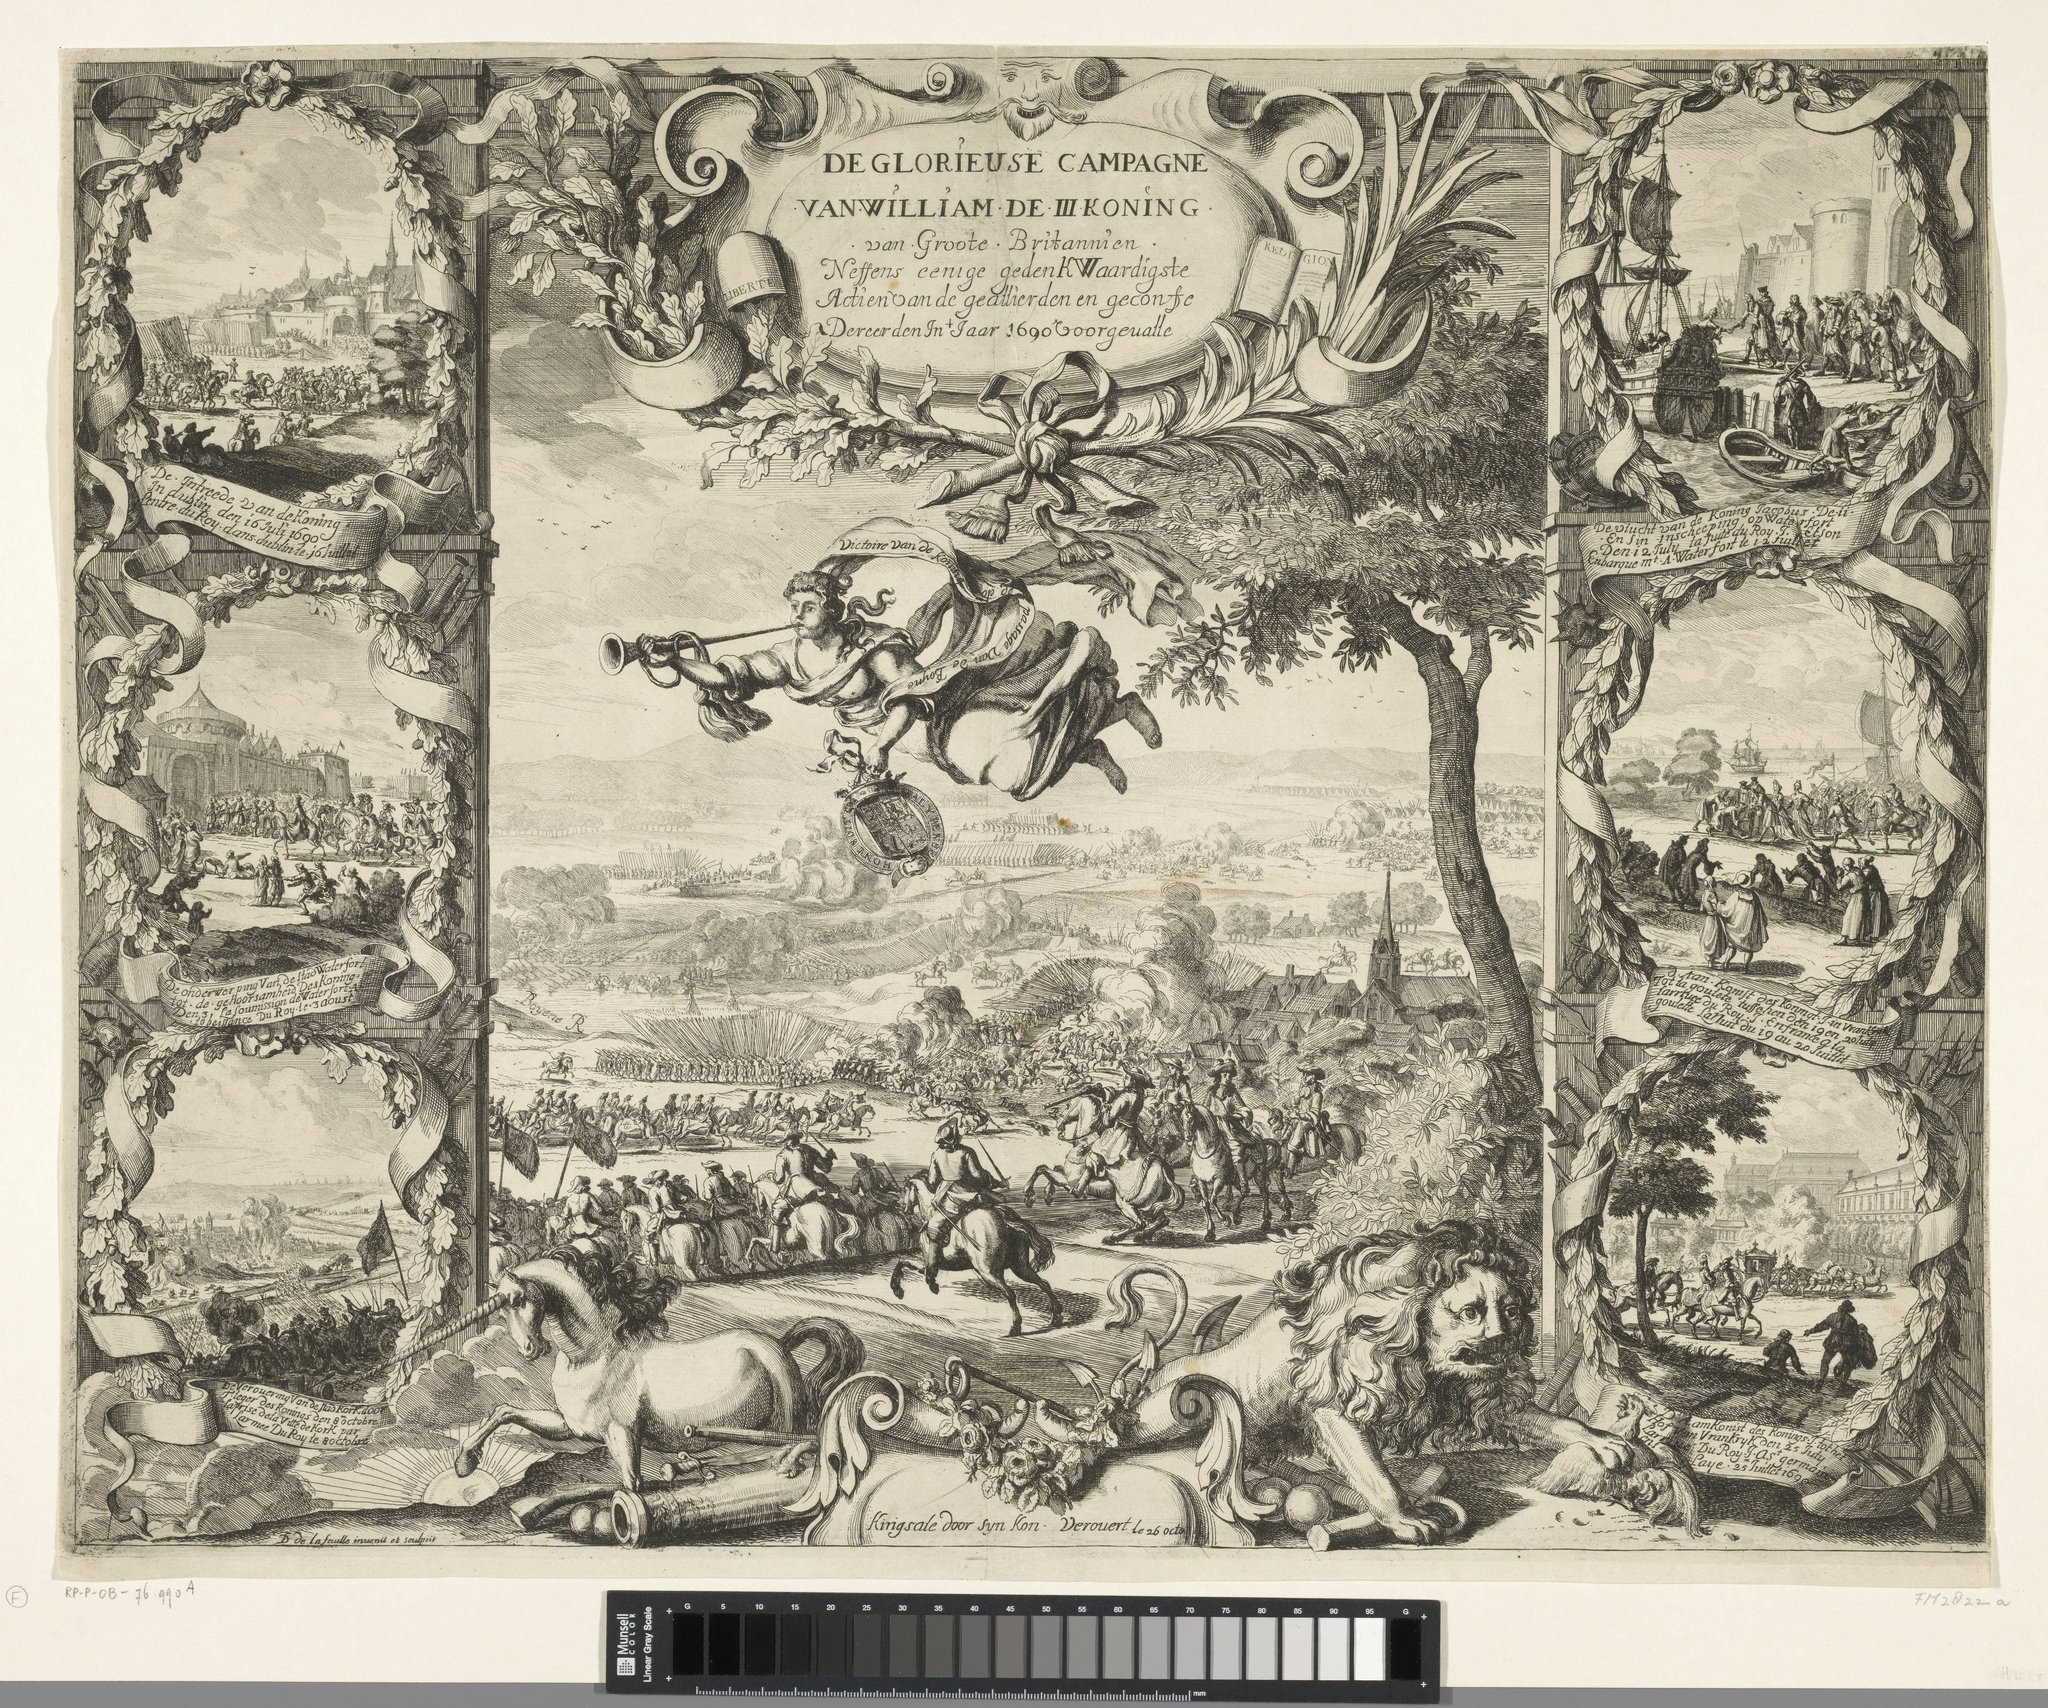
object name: print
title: Overwinningen van koning Willem III in Ierland (bovenste helft), 1690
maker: daniel de lafeuille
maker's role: print maker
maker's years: 1640-1709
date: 1690-1691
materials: paper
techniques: etching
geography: northern netherlands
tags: jacobus ii (koning van engeland en schotland), the hague, william iii (prince of orange and king of england, scotland, and ireland), fame; 'fama', 'fama buona', 'fama chiara' (ripa), battle (+ land forces)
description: Grote prent op twee bladen waarin de overwinningen van koning Willem III in Ierland en de overwinningen van de geallieerden op Frankrijk in het jaar 1690 gevierd worden. Bovenste helft met centraal de slag aan de Boyne op 11 juli 1690. Met Faam in de lucht en vooraan de Engelse eenhoorn en de Hollandse leeuw. Aan weerszijden zes kleinere scènes van de strijd tussen Willem III en Jacobus II.